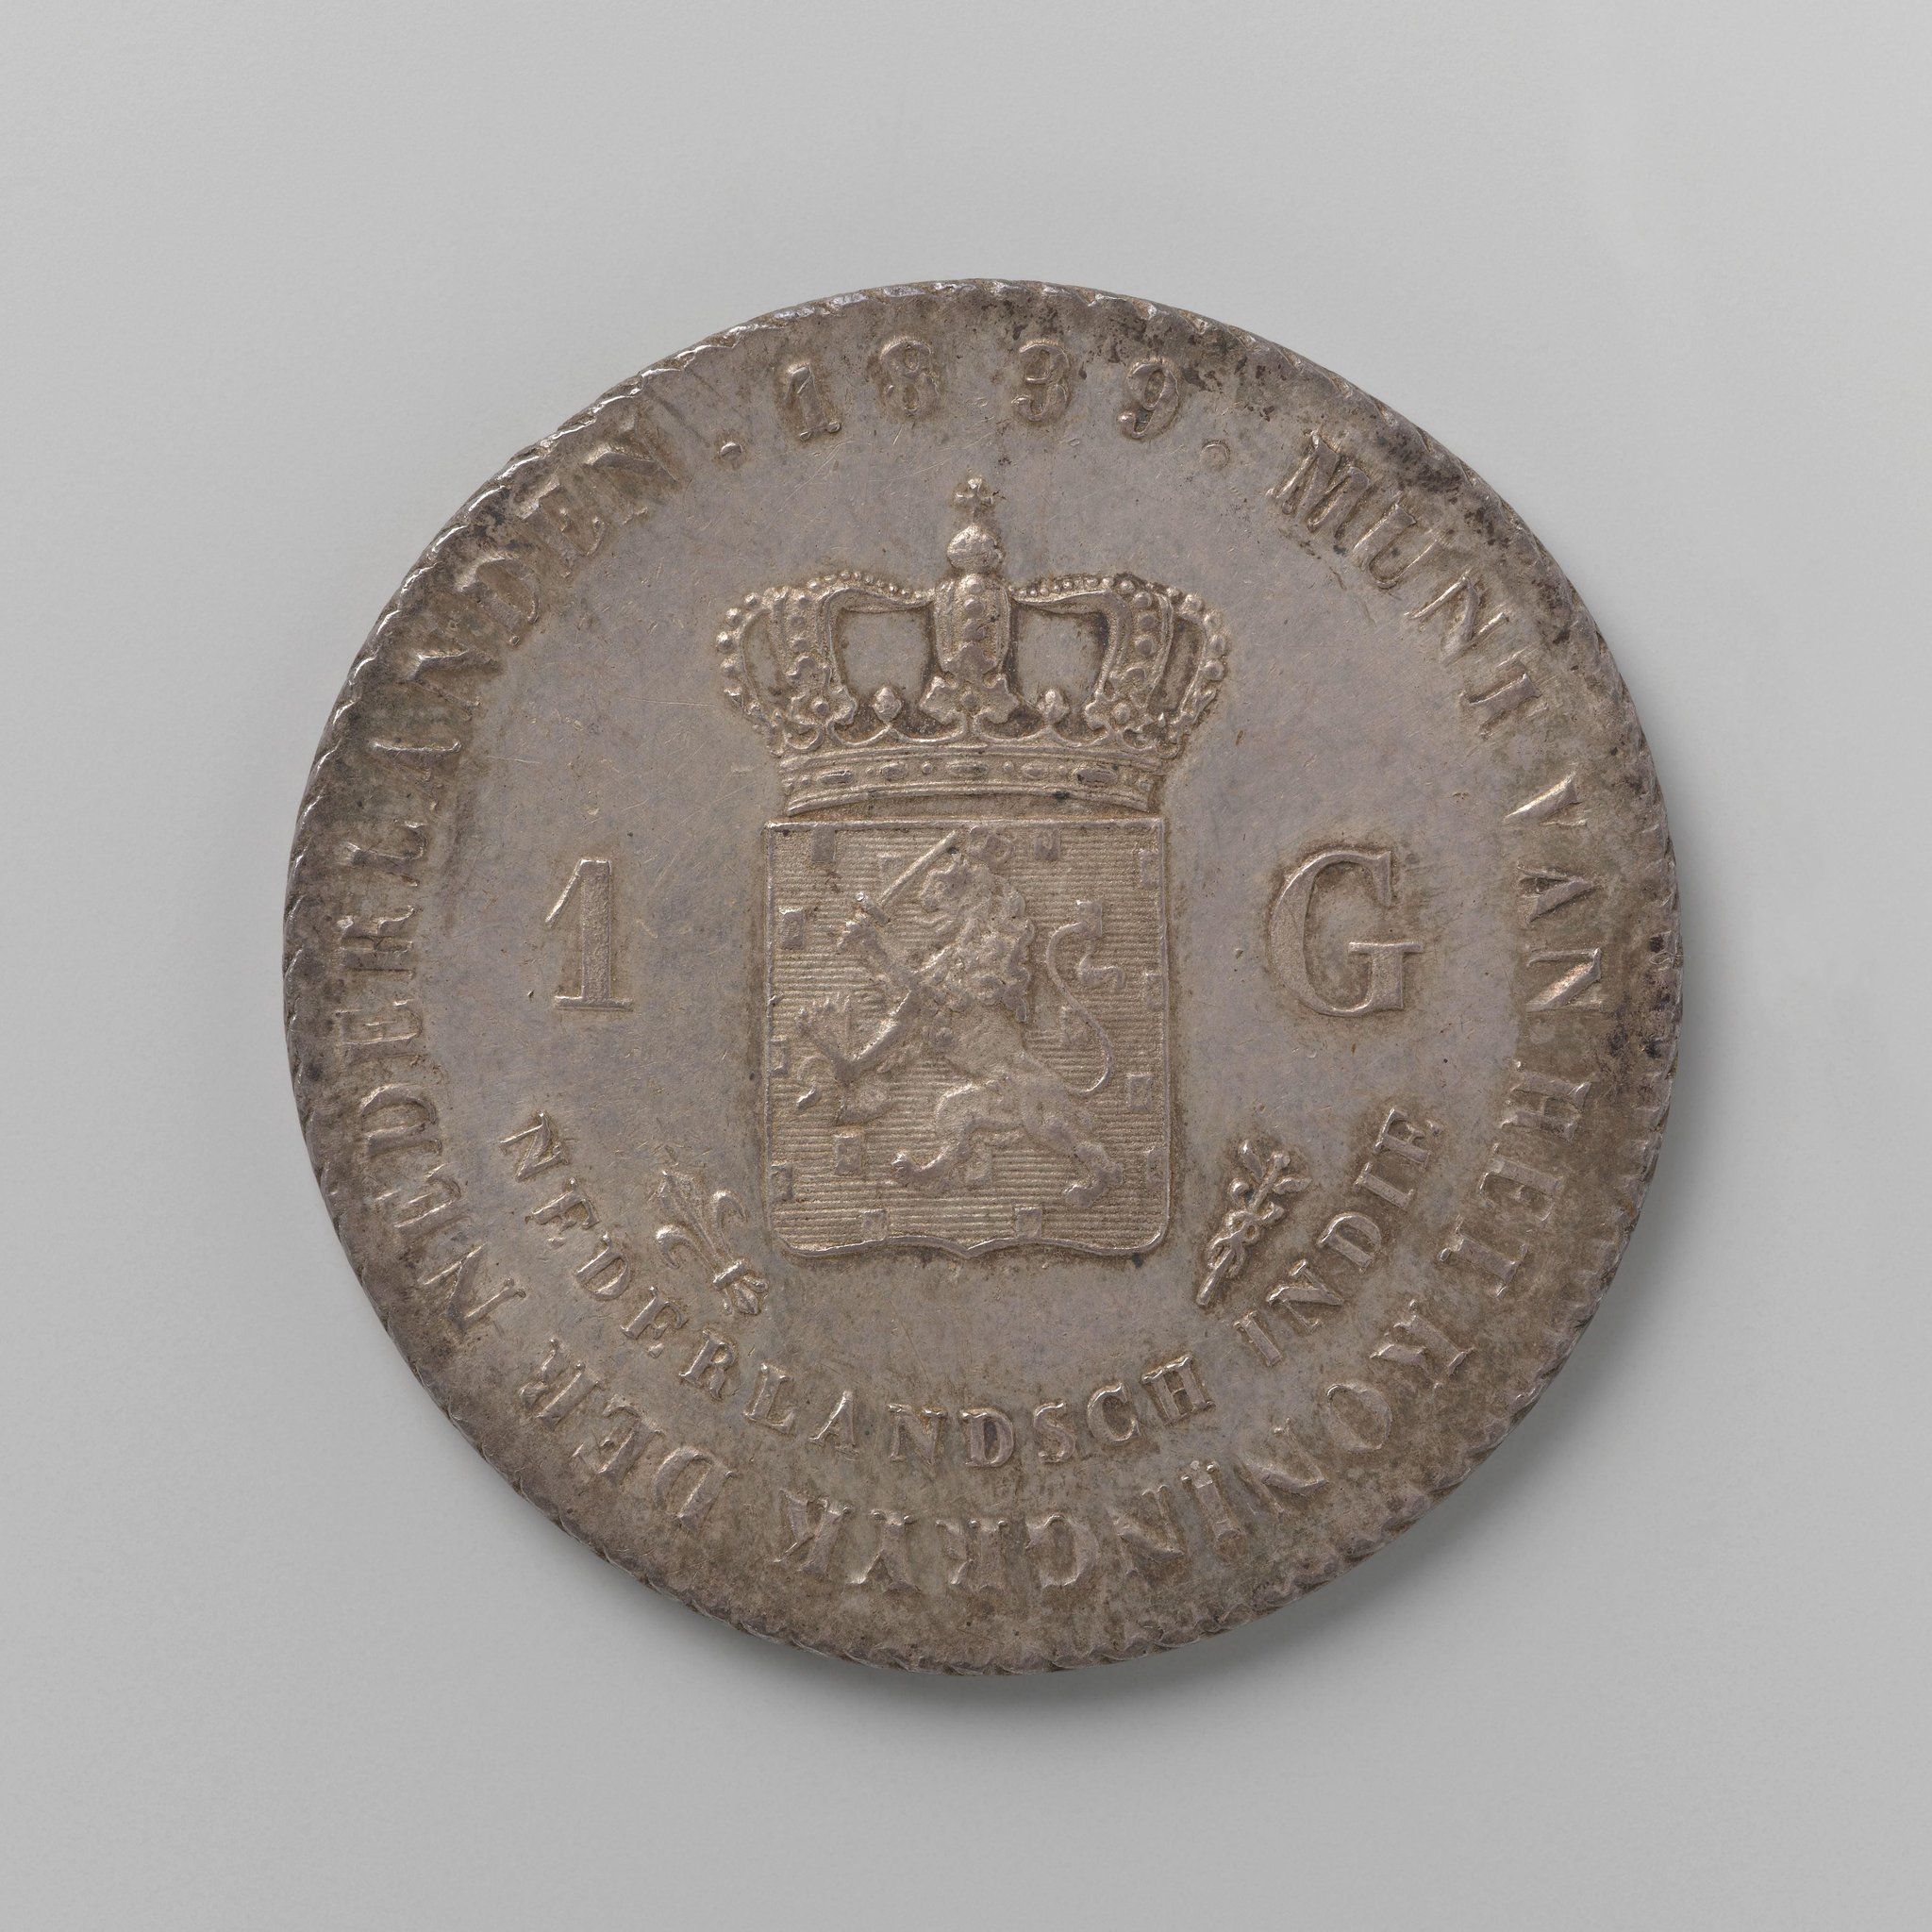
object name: coin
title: Nederlands Indië, gulden, 1839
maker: william i of the netherlands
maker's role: koning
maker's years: 1772-1843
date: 1839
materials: silver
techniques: striking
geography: utrecht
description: Zilveren munt. Voorzijde: borstbeeld naar rechts. Keerzijde: tussen waarde-aanduiding 1 G gekroond rijkswapenschild. Onder het wapenschild in gebogen lijn lands-aanduiding: Nederlandsch Indië. Jaartal boven kroon. Kabelrand.